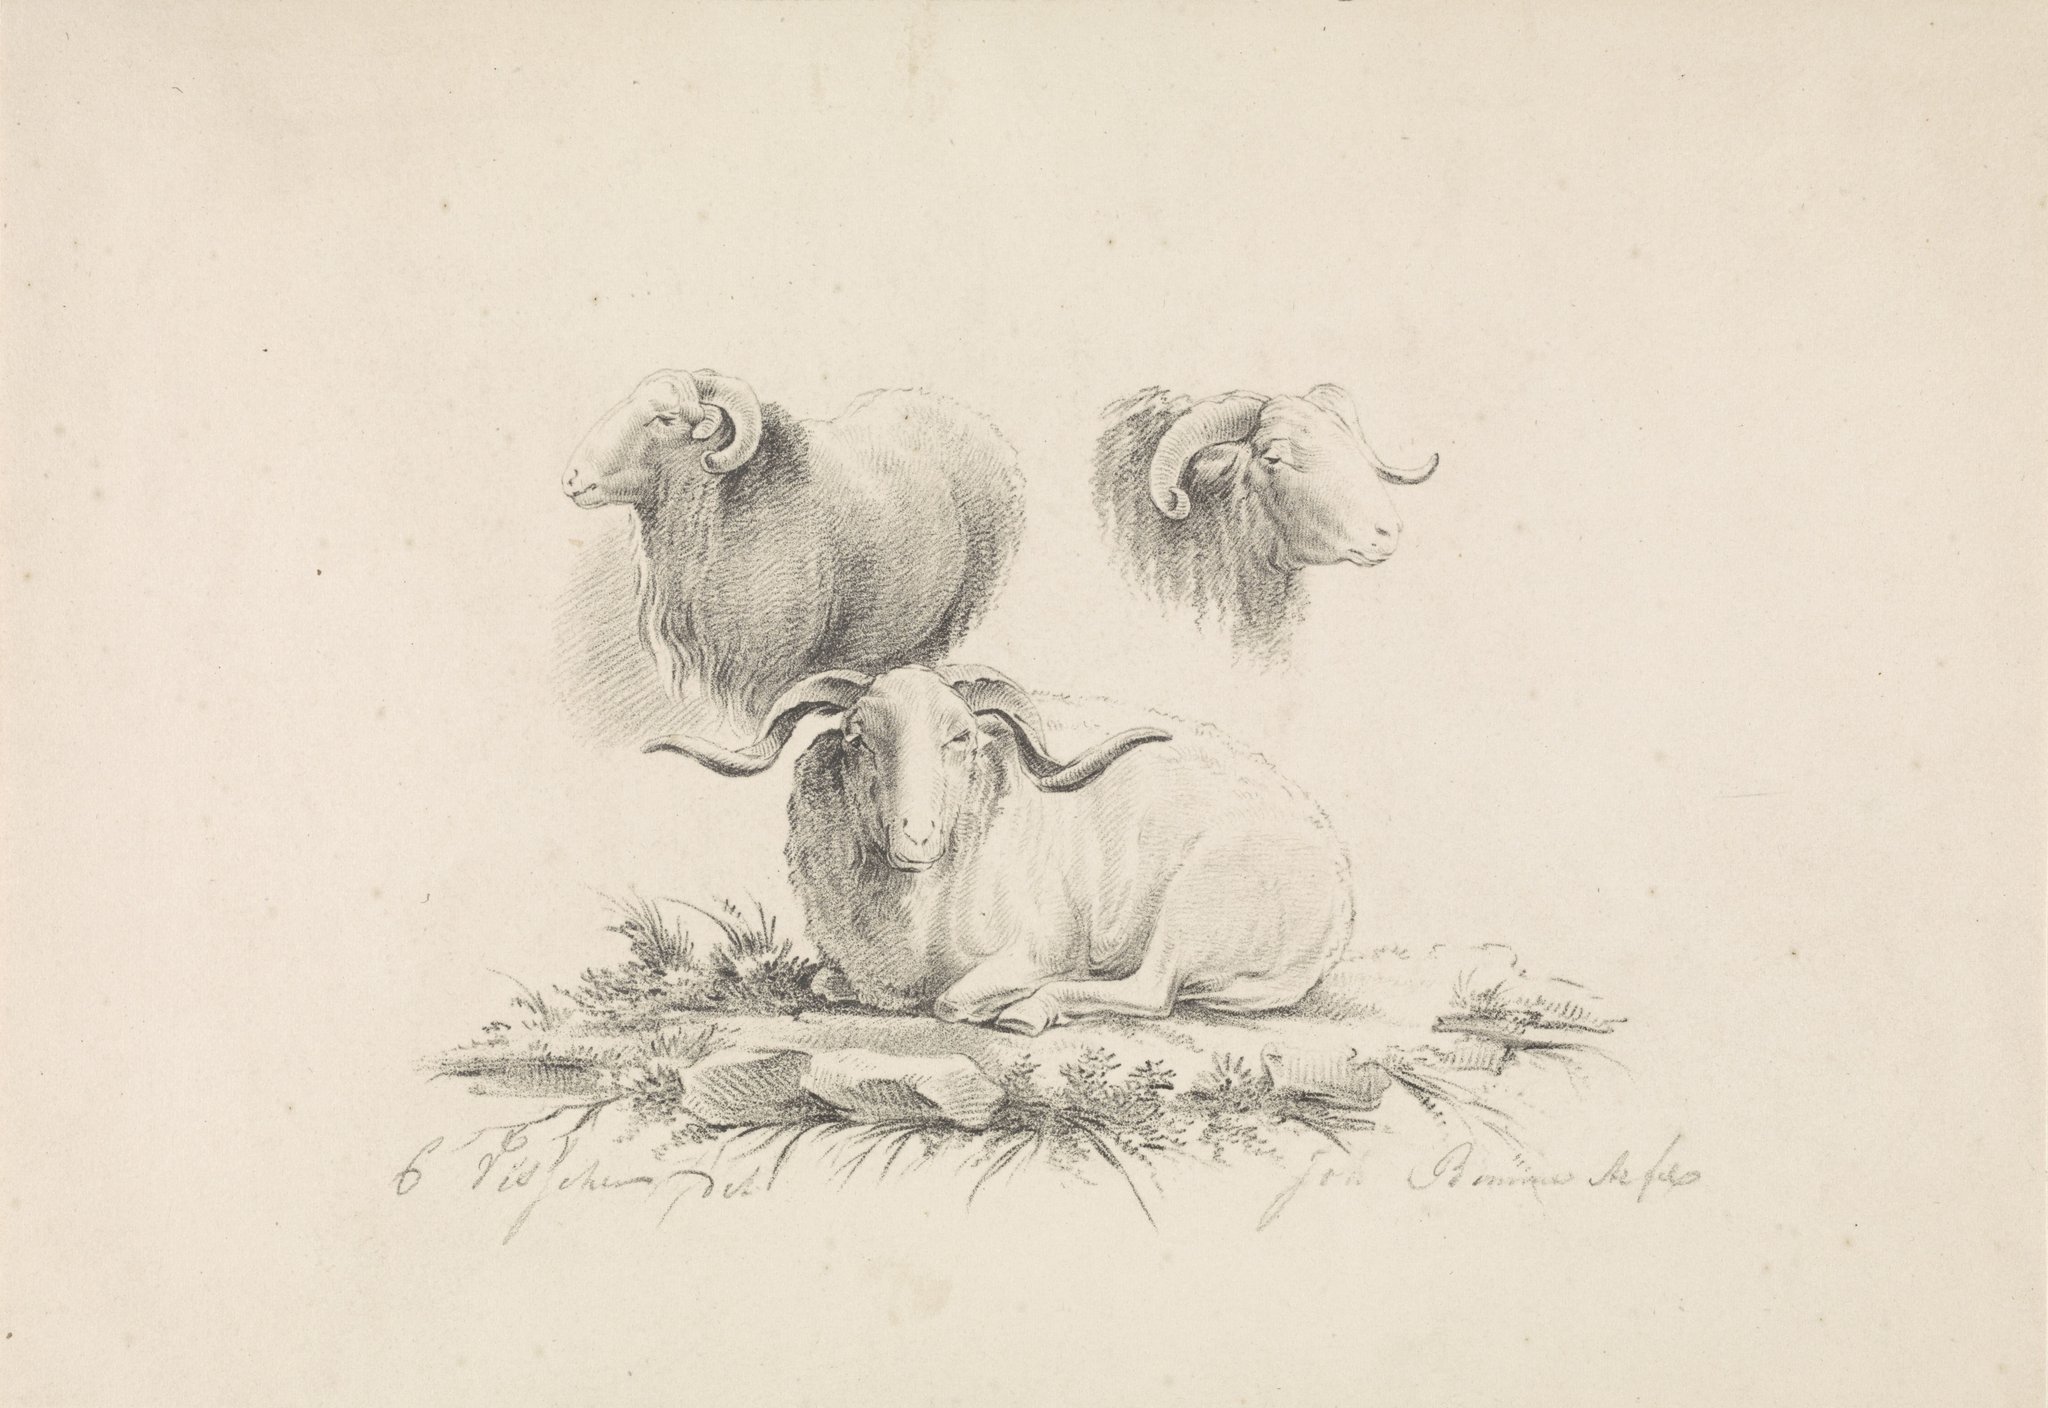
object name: print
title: Studies naar een ram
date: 1809-1841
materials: paper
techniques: lithograph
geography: netherlands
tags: ram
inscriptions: collector's mark: Lugt 2228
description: In het midden ligt een ram met gekrulde horens in het gras. De kop is frontaal afgebeeld. Daarboven is de ram nog twee keer afgebeeld naar links en naar rechts kijkend.